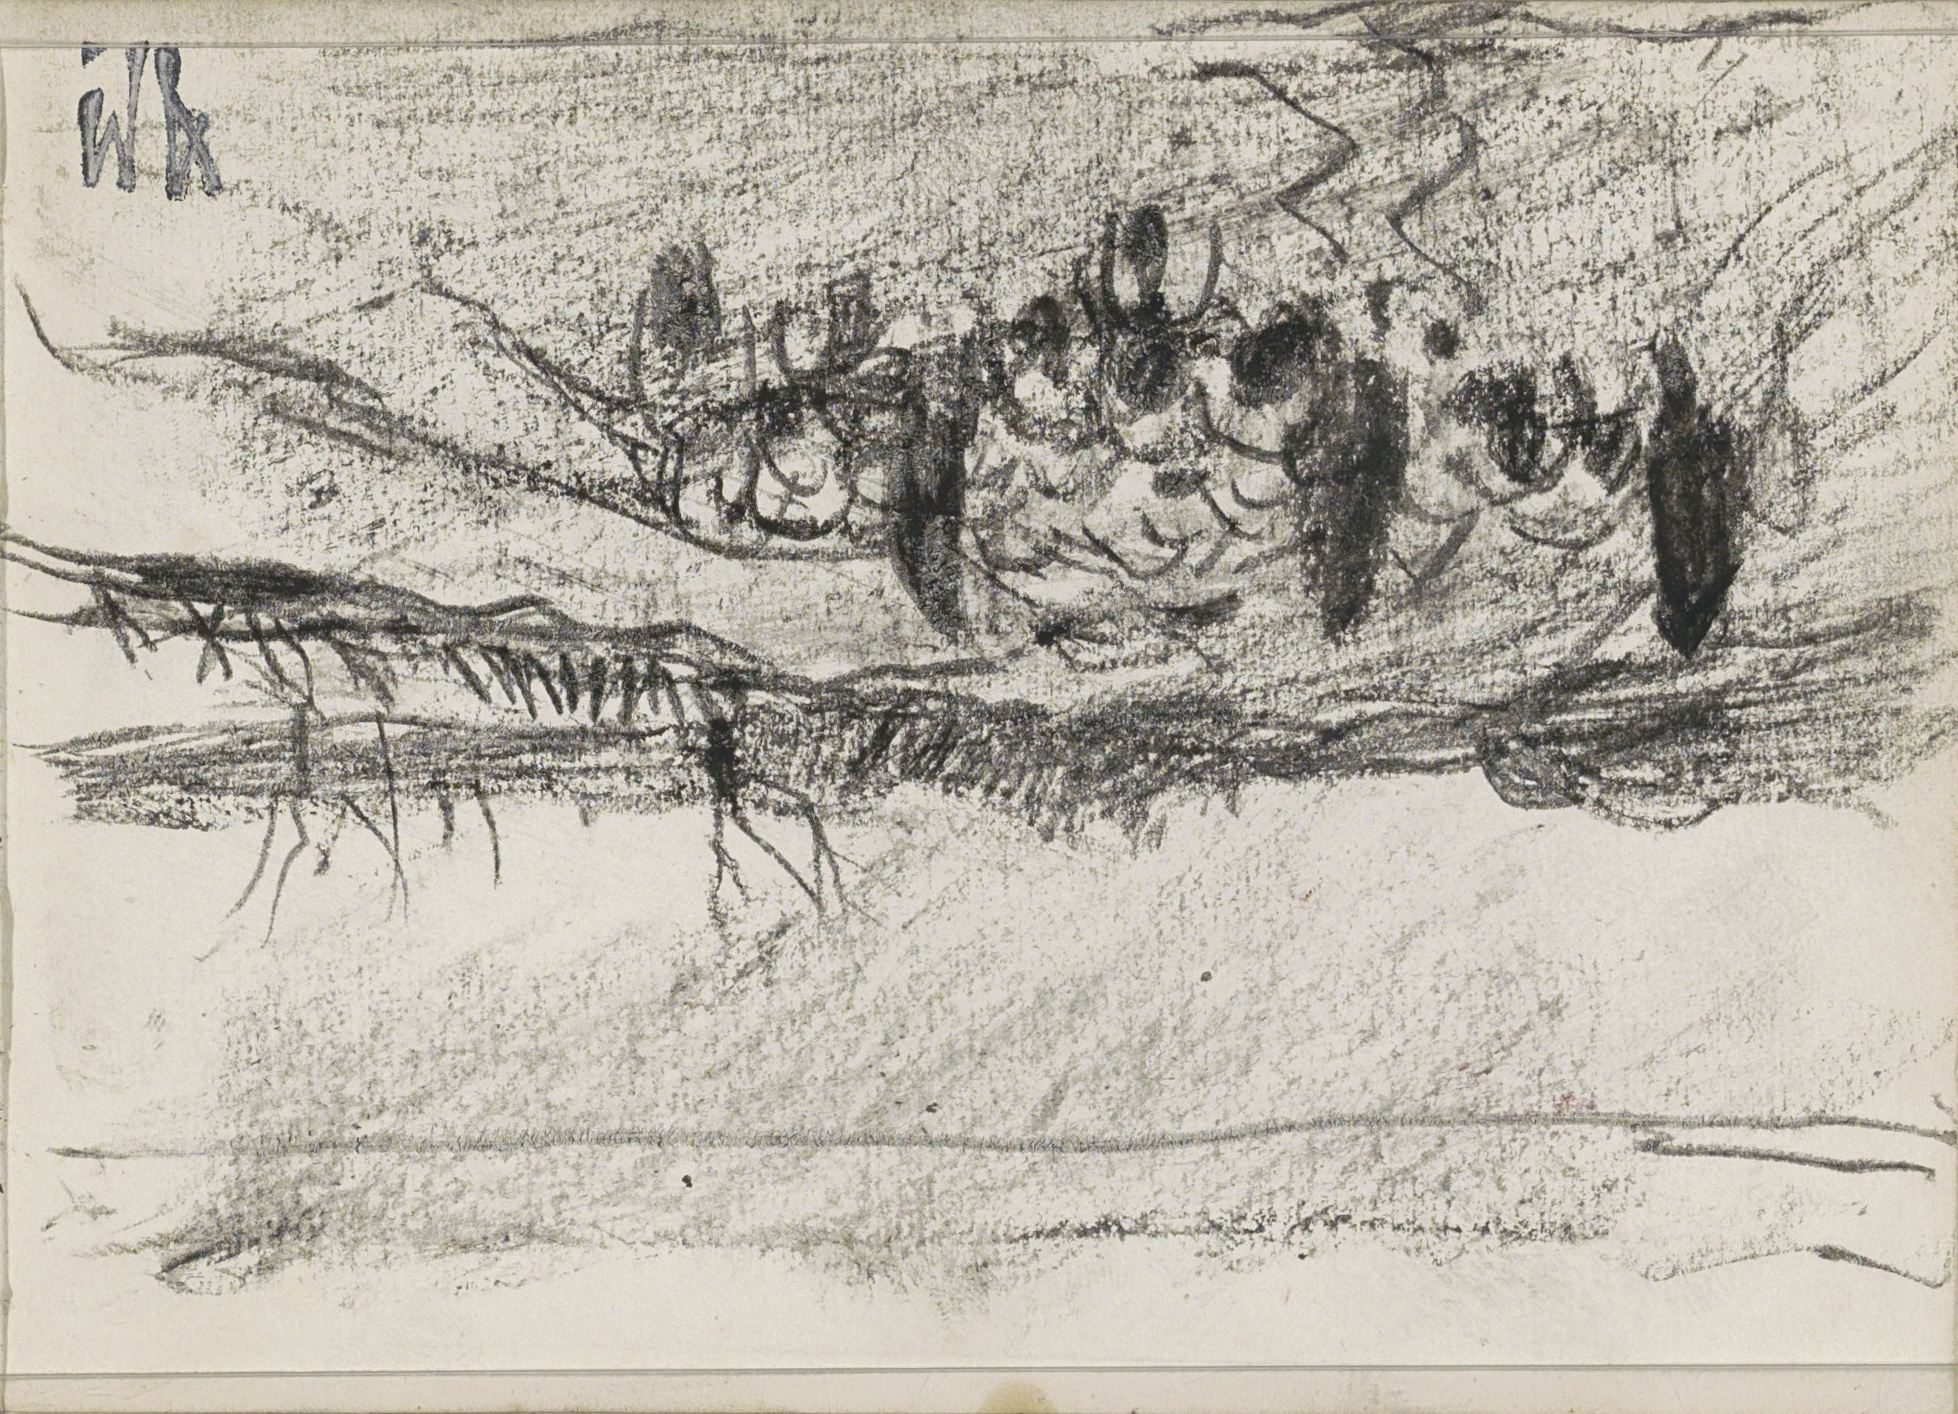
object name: sketchbook leaf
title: Herders met een schaapskudde in een landschap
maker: anton mauve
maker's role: draughtsman, painter, print maker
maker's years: 1838-1888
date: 1848-1888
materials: chalk, paper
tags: herding, herdsman, herdswoman, shepherd, shepherdess, cowherd, etc., sheep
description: Blad 5 recto uit een schetsboek met 31 bladen.